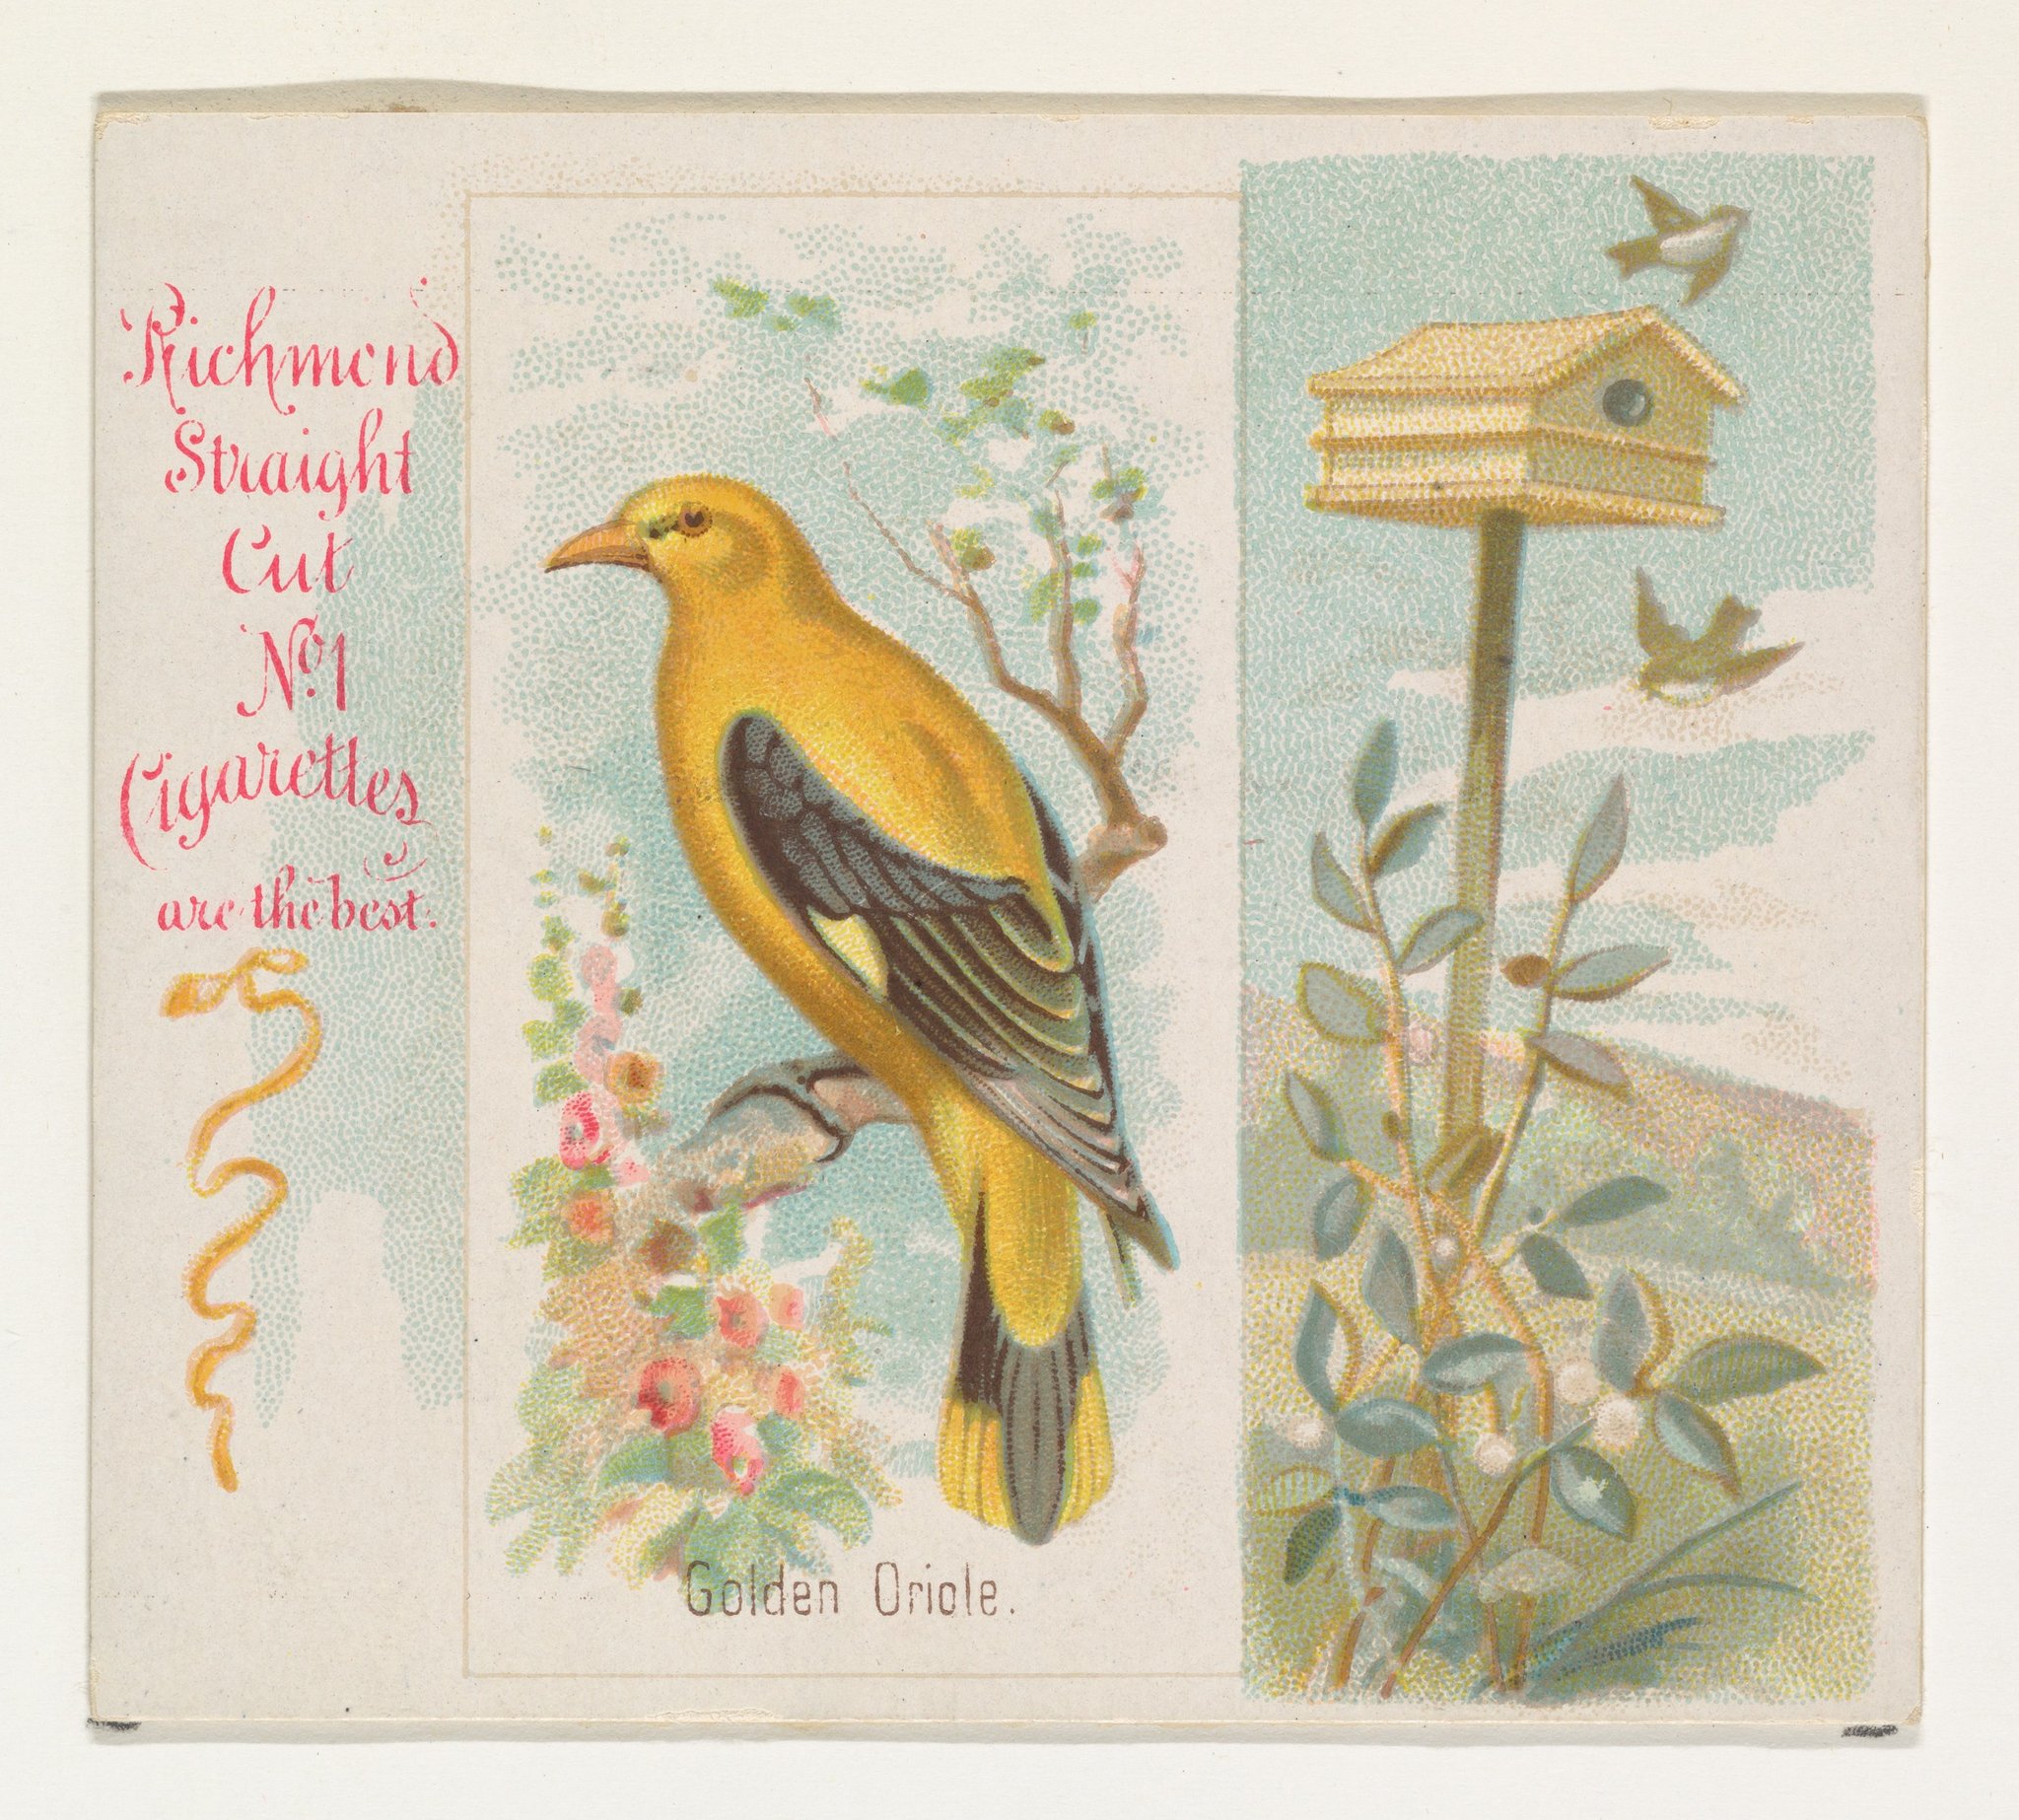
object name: print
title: Golden Oriole, from the Song Birds of the World series (N42) for Allen & Ginter Cigarettes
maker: allen & ginter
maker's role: publisher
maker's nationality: american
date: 1890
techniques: color lithograph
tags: birds